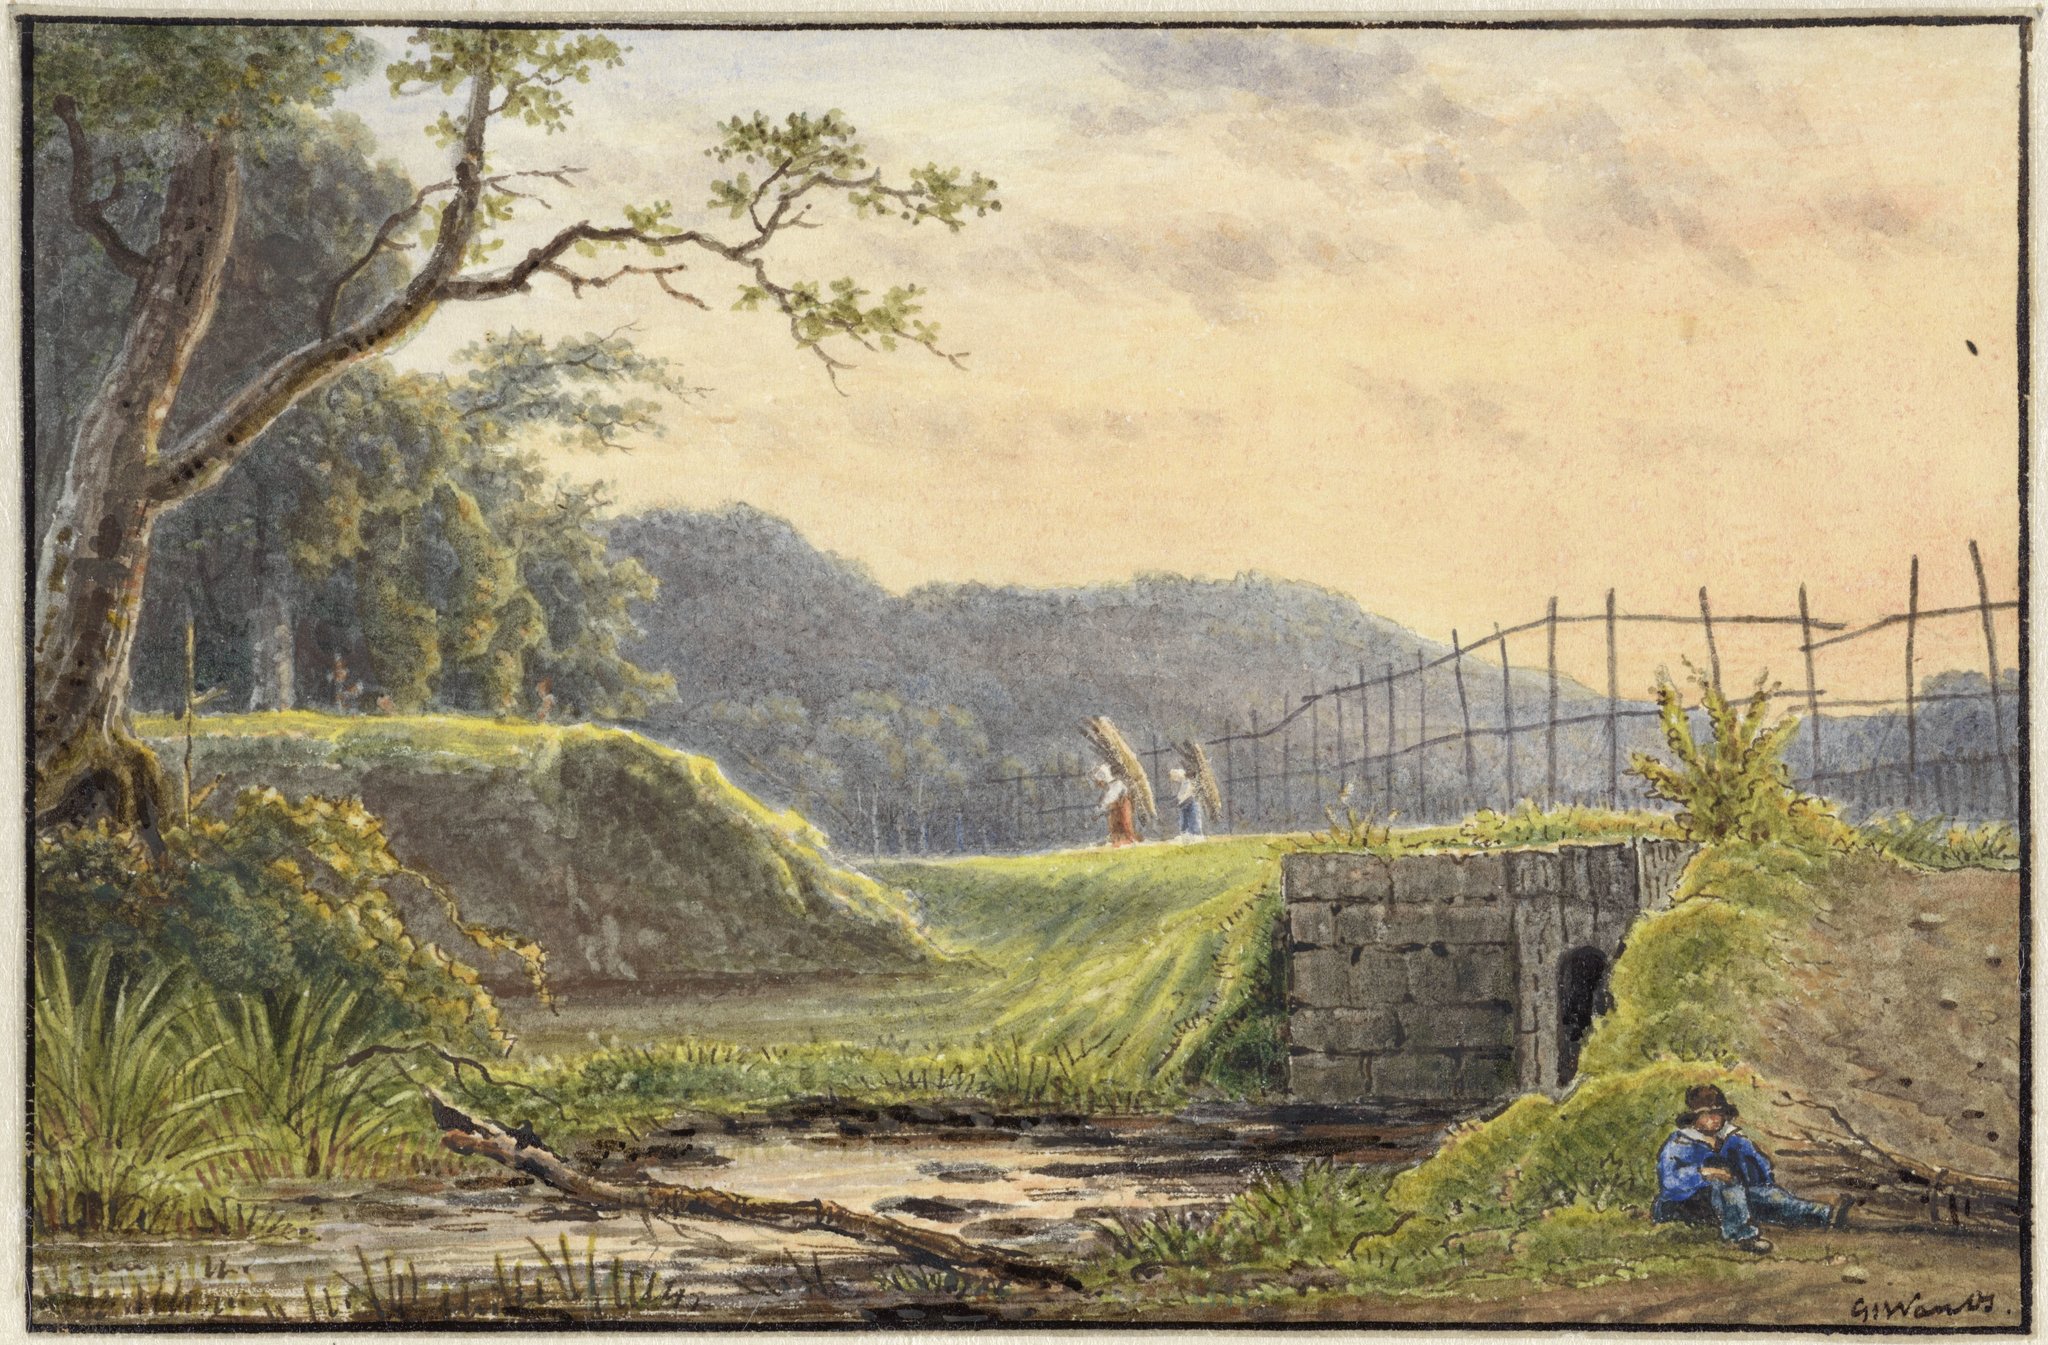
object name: drawing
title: Landschap met brug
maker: georgius jacobus johannes van os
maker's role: draughtsman, painter, print maker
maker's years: 1782-1861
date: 1792-1861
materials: ink, paper, watercolor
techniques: brush, pen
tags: landscape with bridge, viaduct or aqueduct